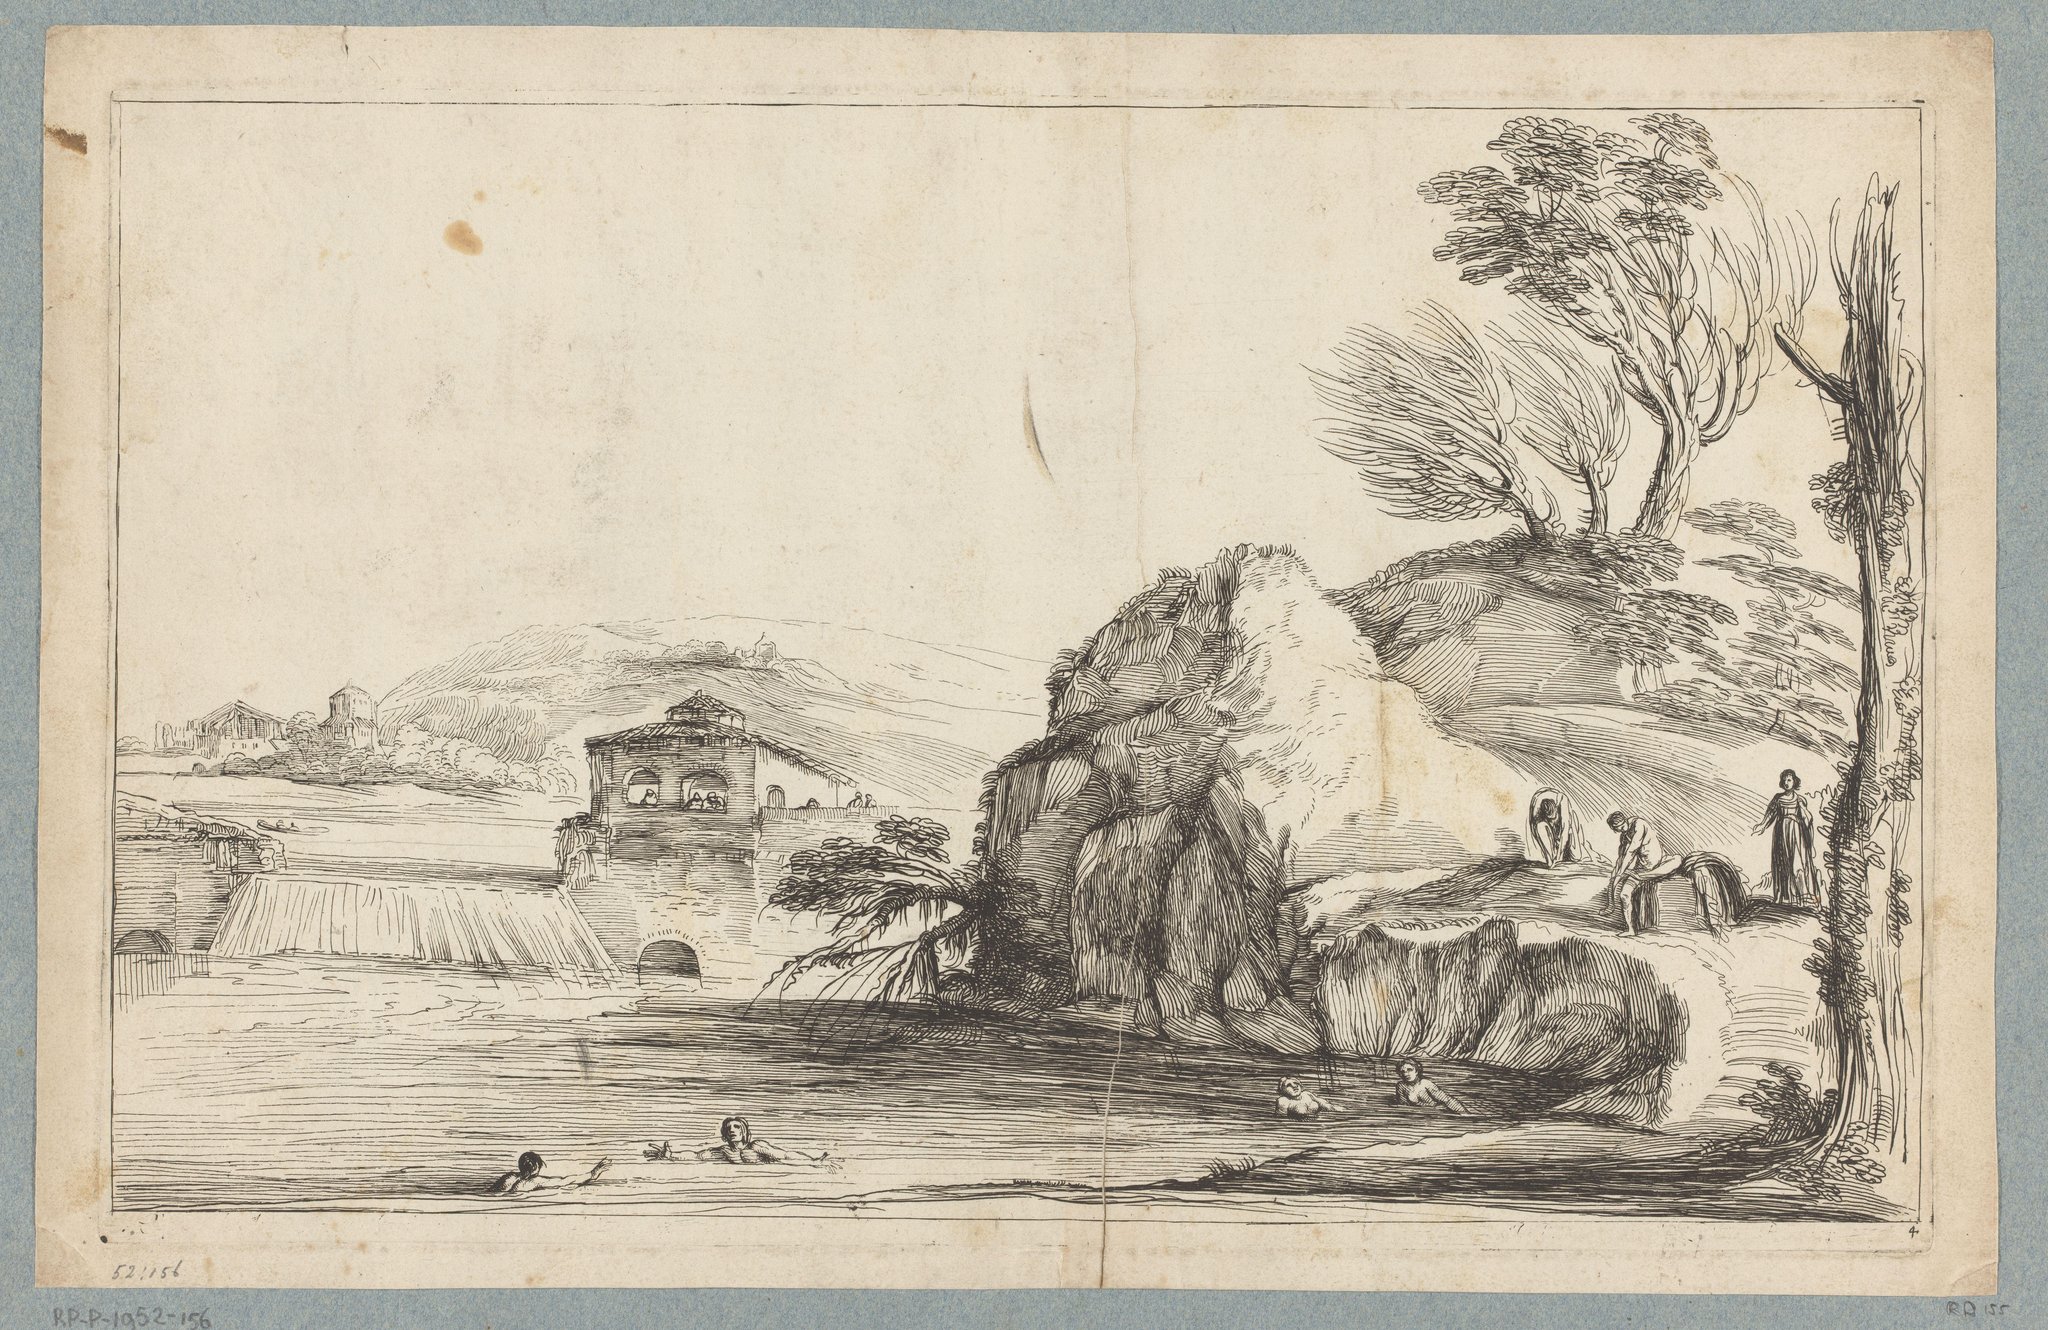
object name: print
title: Prenten naar tekeningen uit het kabinet Jabach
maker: jean pesne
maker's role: print maker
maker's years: 1623-1700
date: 1666-1695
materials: paper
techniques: etching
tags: landscapes, water course, swimming (movement in water), taking a bath - aa - in the open air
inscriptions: number: ‘4’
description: Prent maakt deel uit van een serie van 283 prenten, ongenummerde staat.